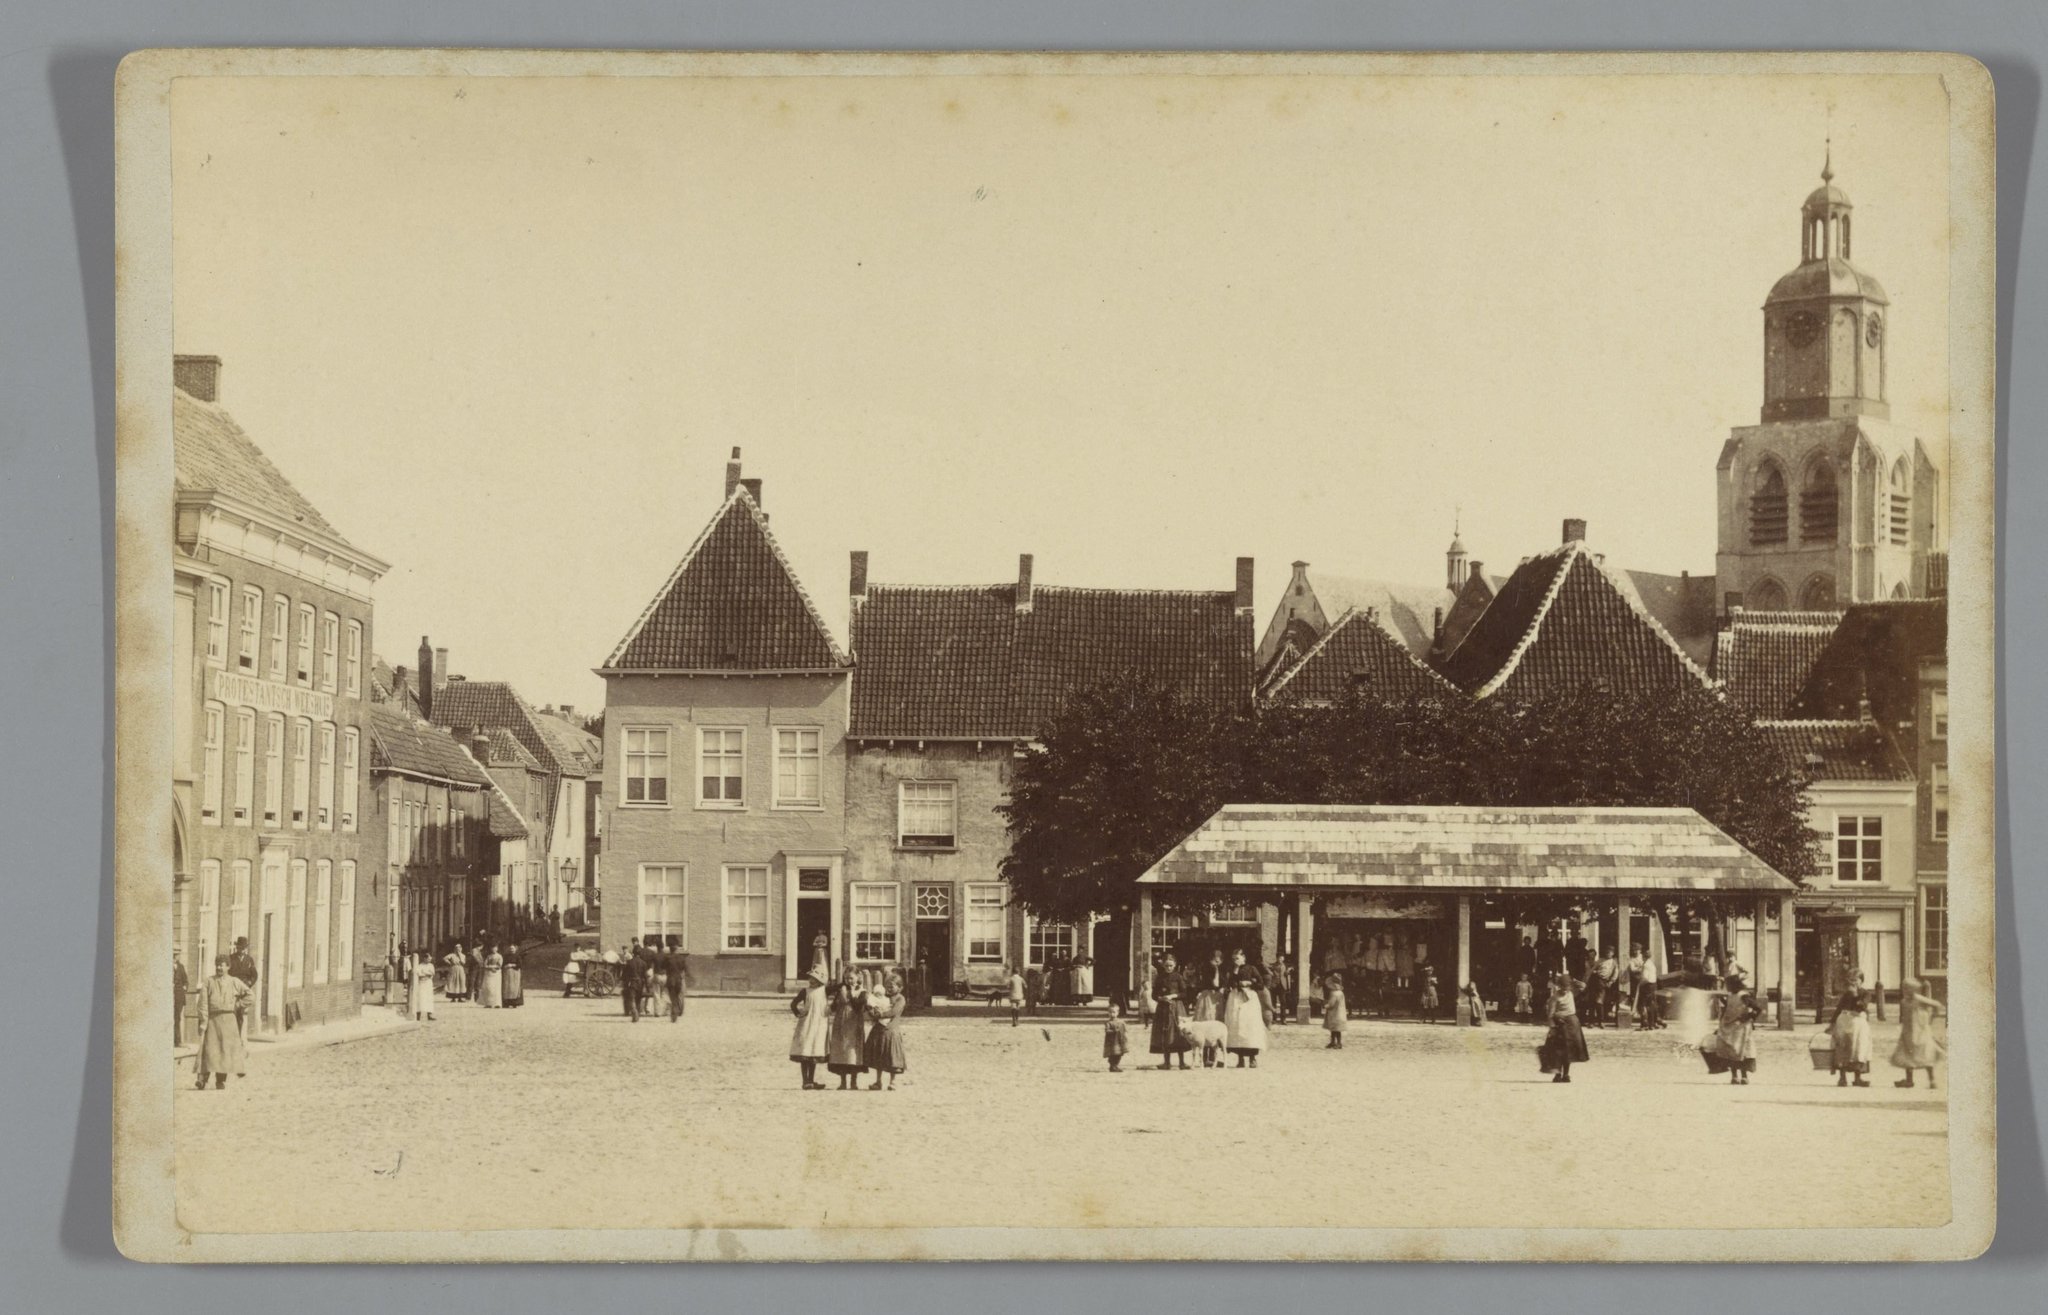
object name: cabinet photograph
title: Plein te Bergen op Zoom, met de toren van de Sint-Gertrudiskerk op de achtergrond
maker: jannis jacobus van melle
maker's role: fotograaf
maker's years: 1829-1911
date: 1880-1900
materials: cardboard, paper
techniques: albumen print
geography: bergen op zoom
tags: square, place, circus, etc., bergen op zoom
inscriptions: inscription: ‘Cabinet-Portrait/ J.J. van Melle/ Photographe/ Bergen op Zoom/ Rijkebuurtstraat’, collector's mark: ‘Vosmaer’